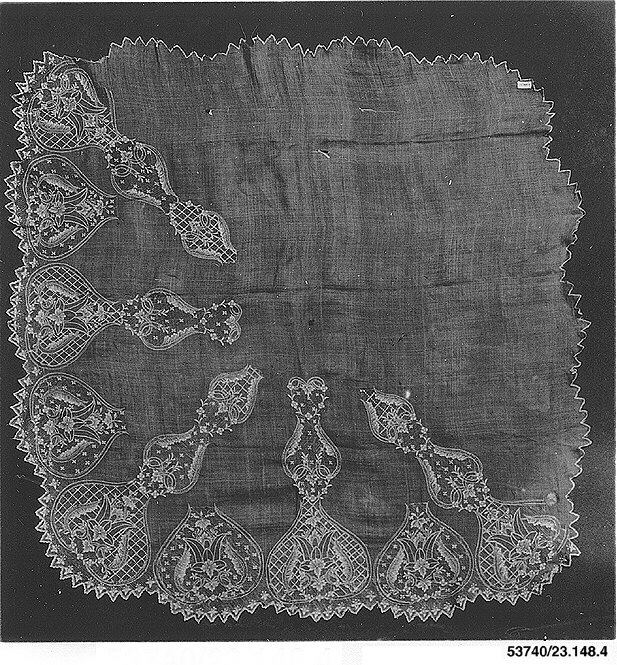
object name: kerchief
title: Kerchief (Pañuelo)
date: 1801-1850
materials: fiber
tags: flowers